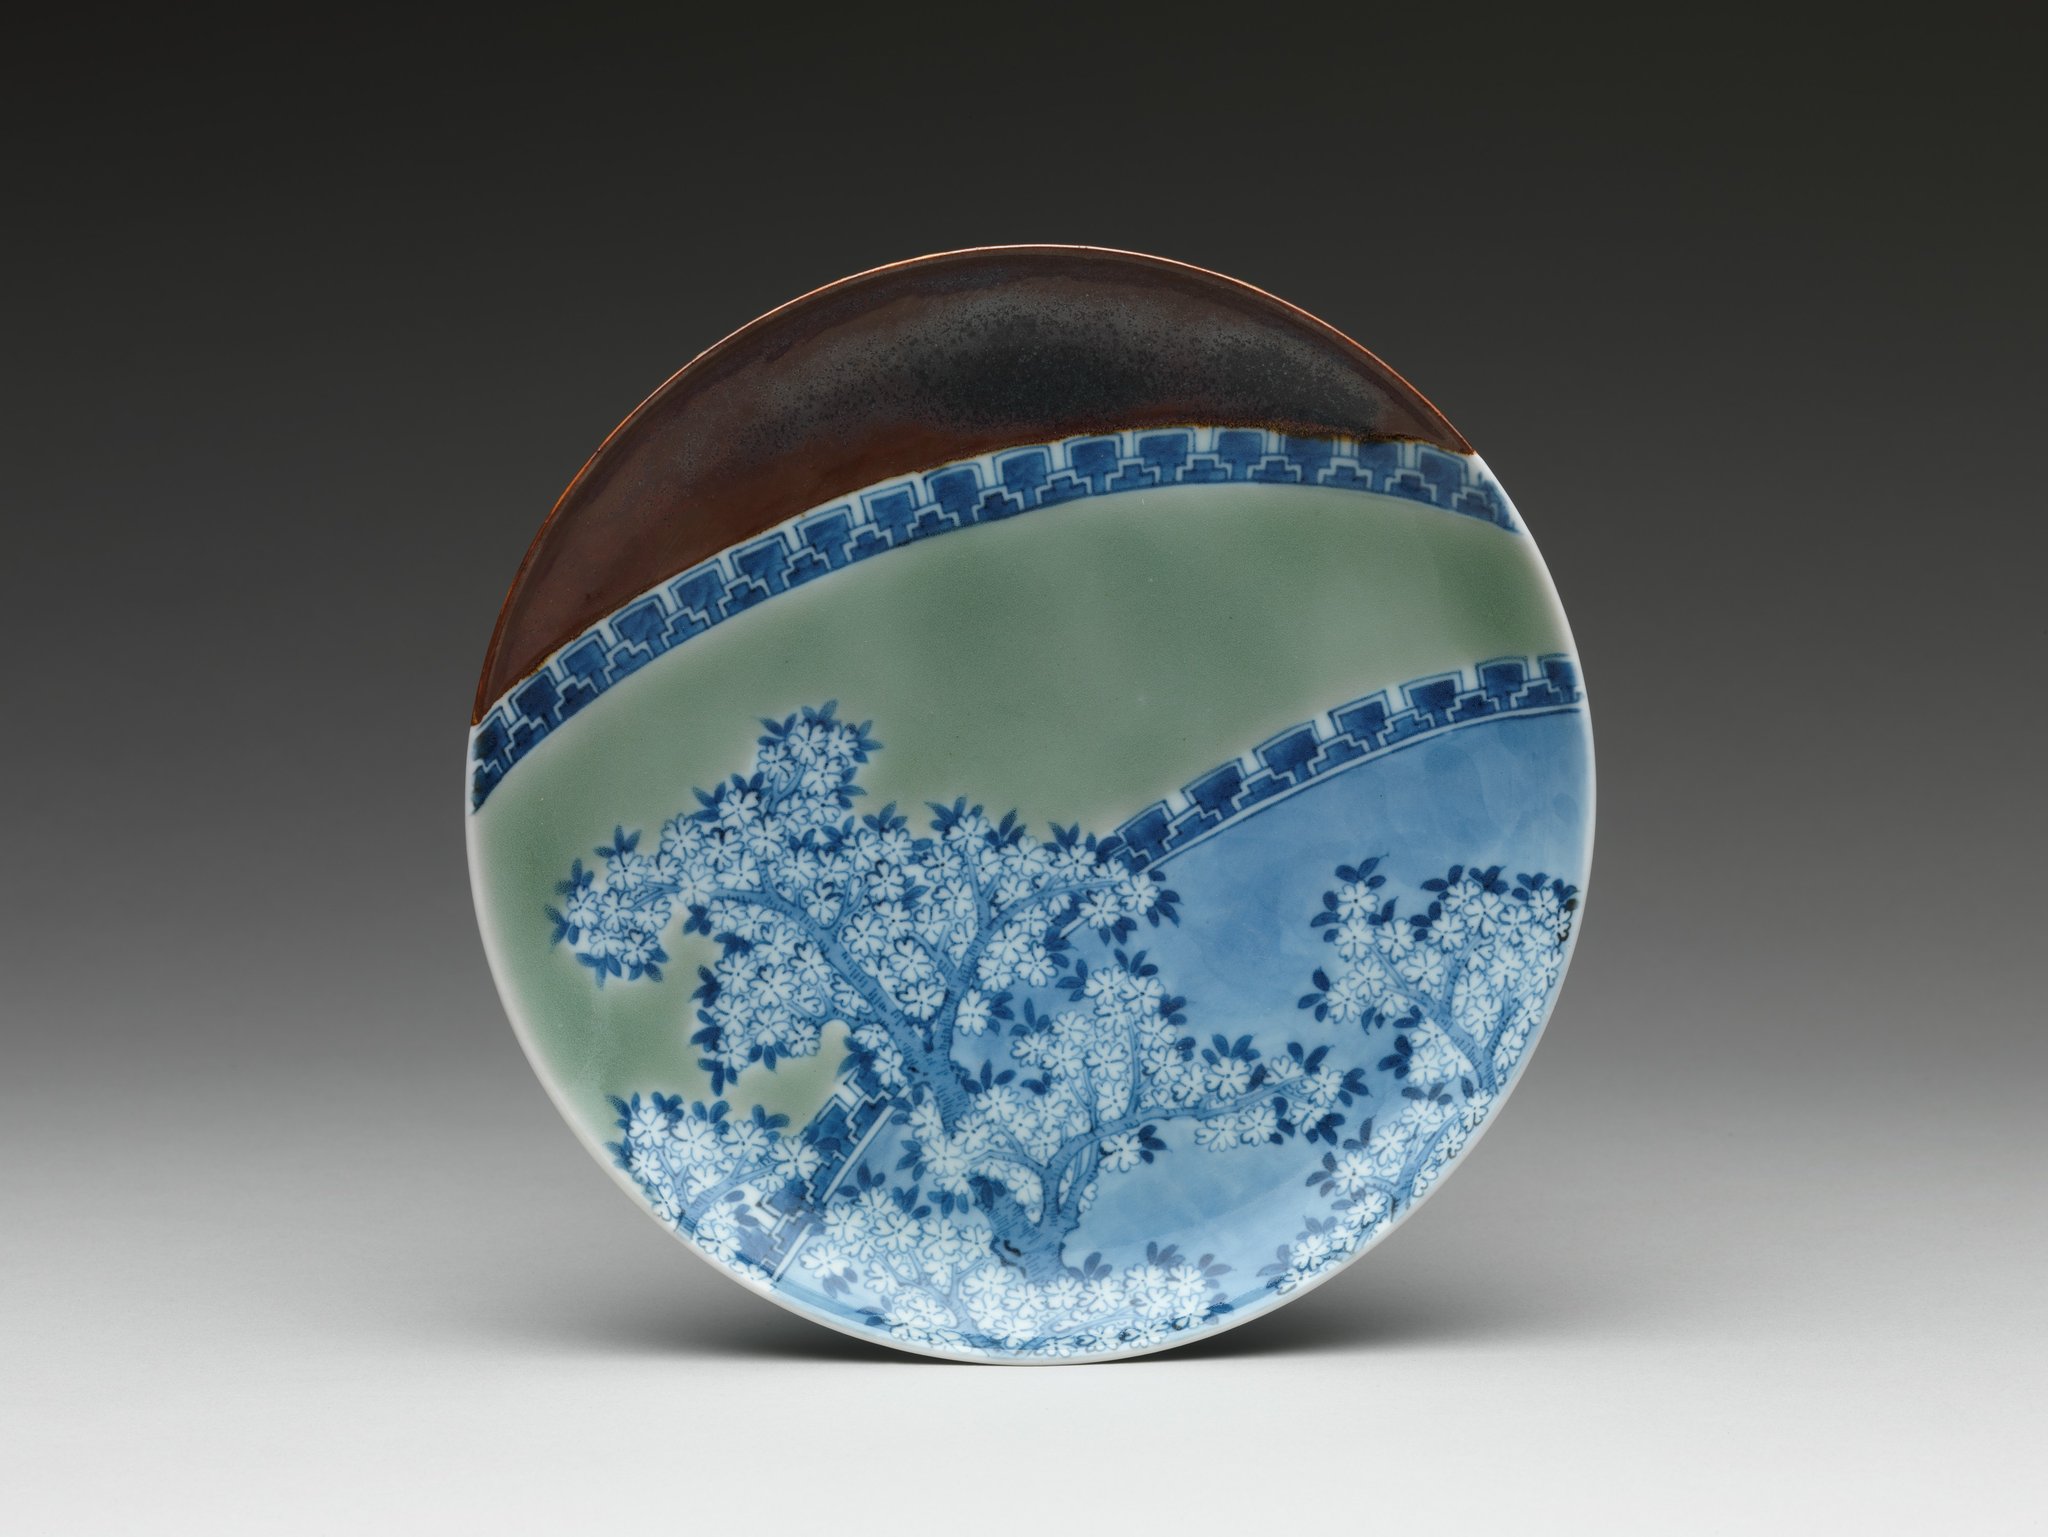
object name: dish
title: Dish with Cherry Blossoms and Textile Curtains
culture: japanese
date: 1670-1690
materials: ceramic glaze, glaze, porcelain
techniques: underglaze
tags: flowers,trees